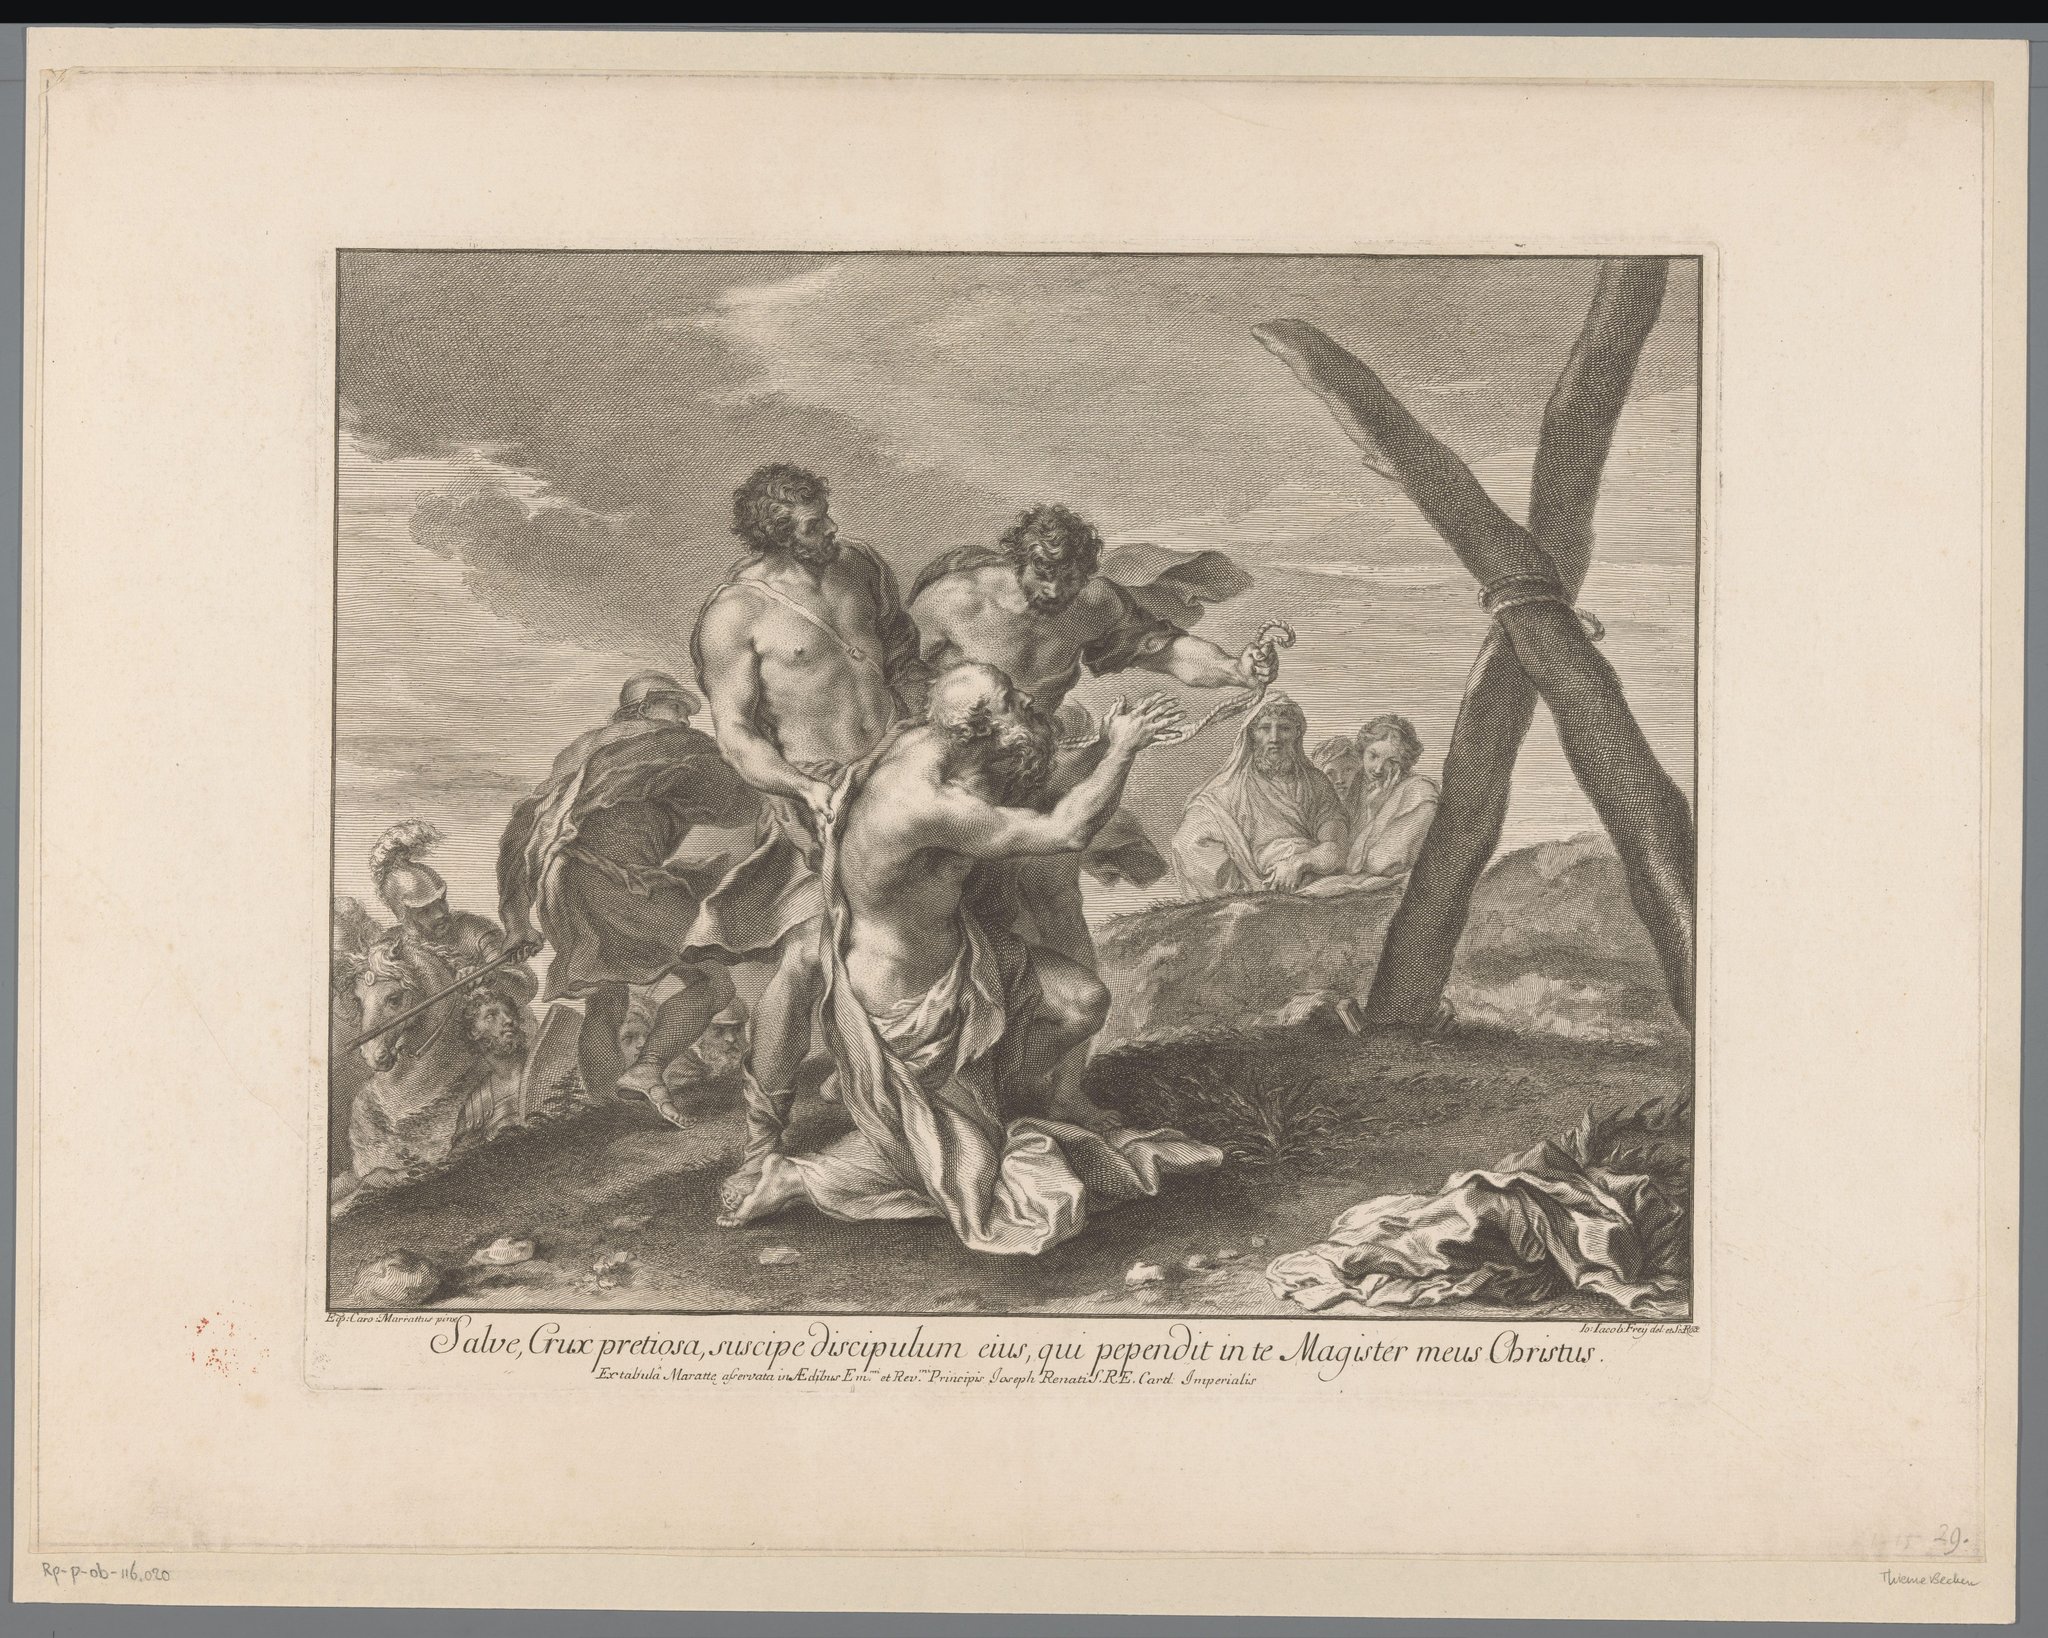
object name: print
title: Heilige Andreas voor zijn kruisiging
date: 1691-1752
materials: paper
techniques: engraving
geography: rome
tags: martyrdom and death of andrew, the apostle andrew; possible attributes: book, x-shaped cross, fish, fishing-net, rope, scroll - martyrdom, suffering, misfortune, death of male saint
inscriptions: collector's mark: Lugt 240